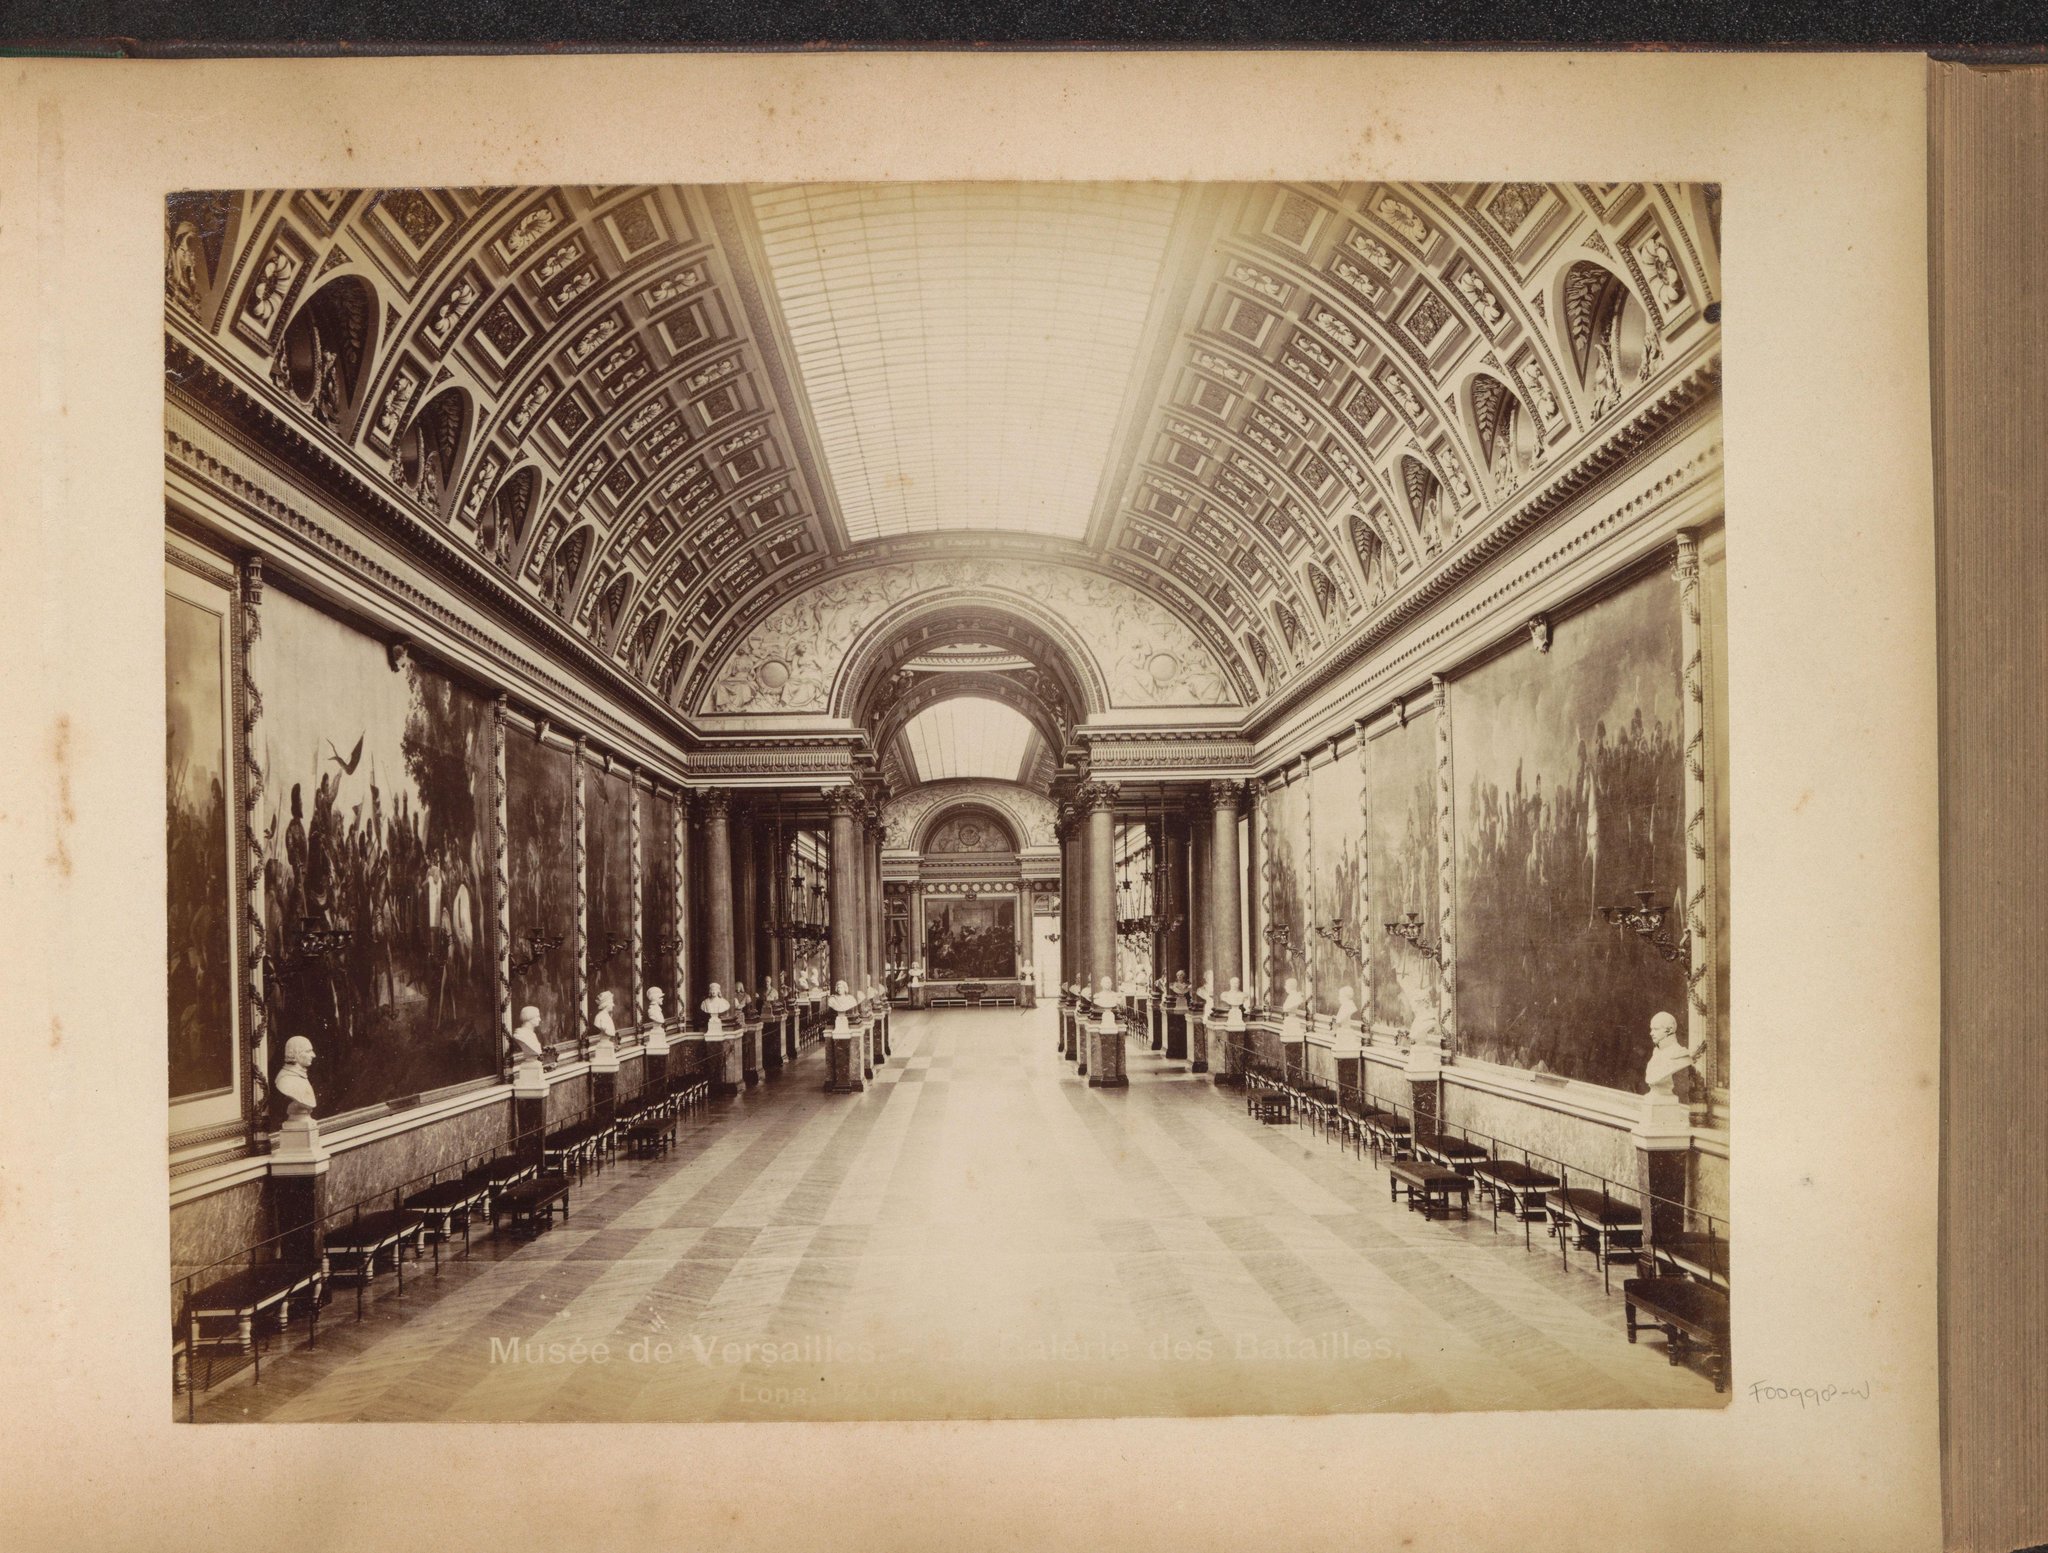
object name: photograph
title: Musée de Versailles. - La Galerie des Batailles. Long. 120 m (...) 13 m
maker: Anonymous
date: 1880-1895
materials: paper, photographic support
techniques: albumen print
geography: versailles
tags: permanent exhibition, museum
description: Onderdeel van Reisalbum met foto's van bezienswaardigheden in Frankrijk, Griekenland en Turkije.